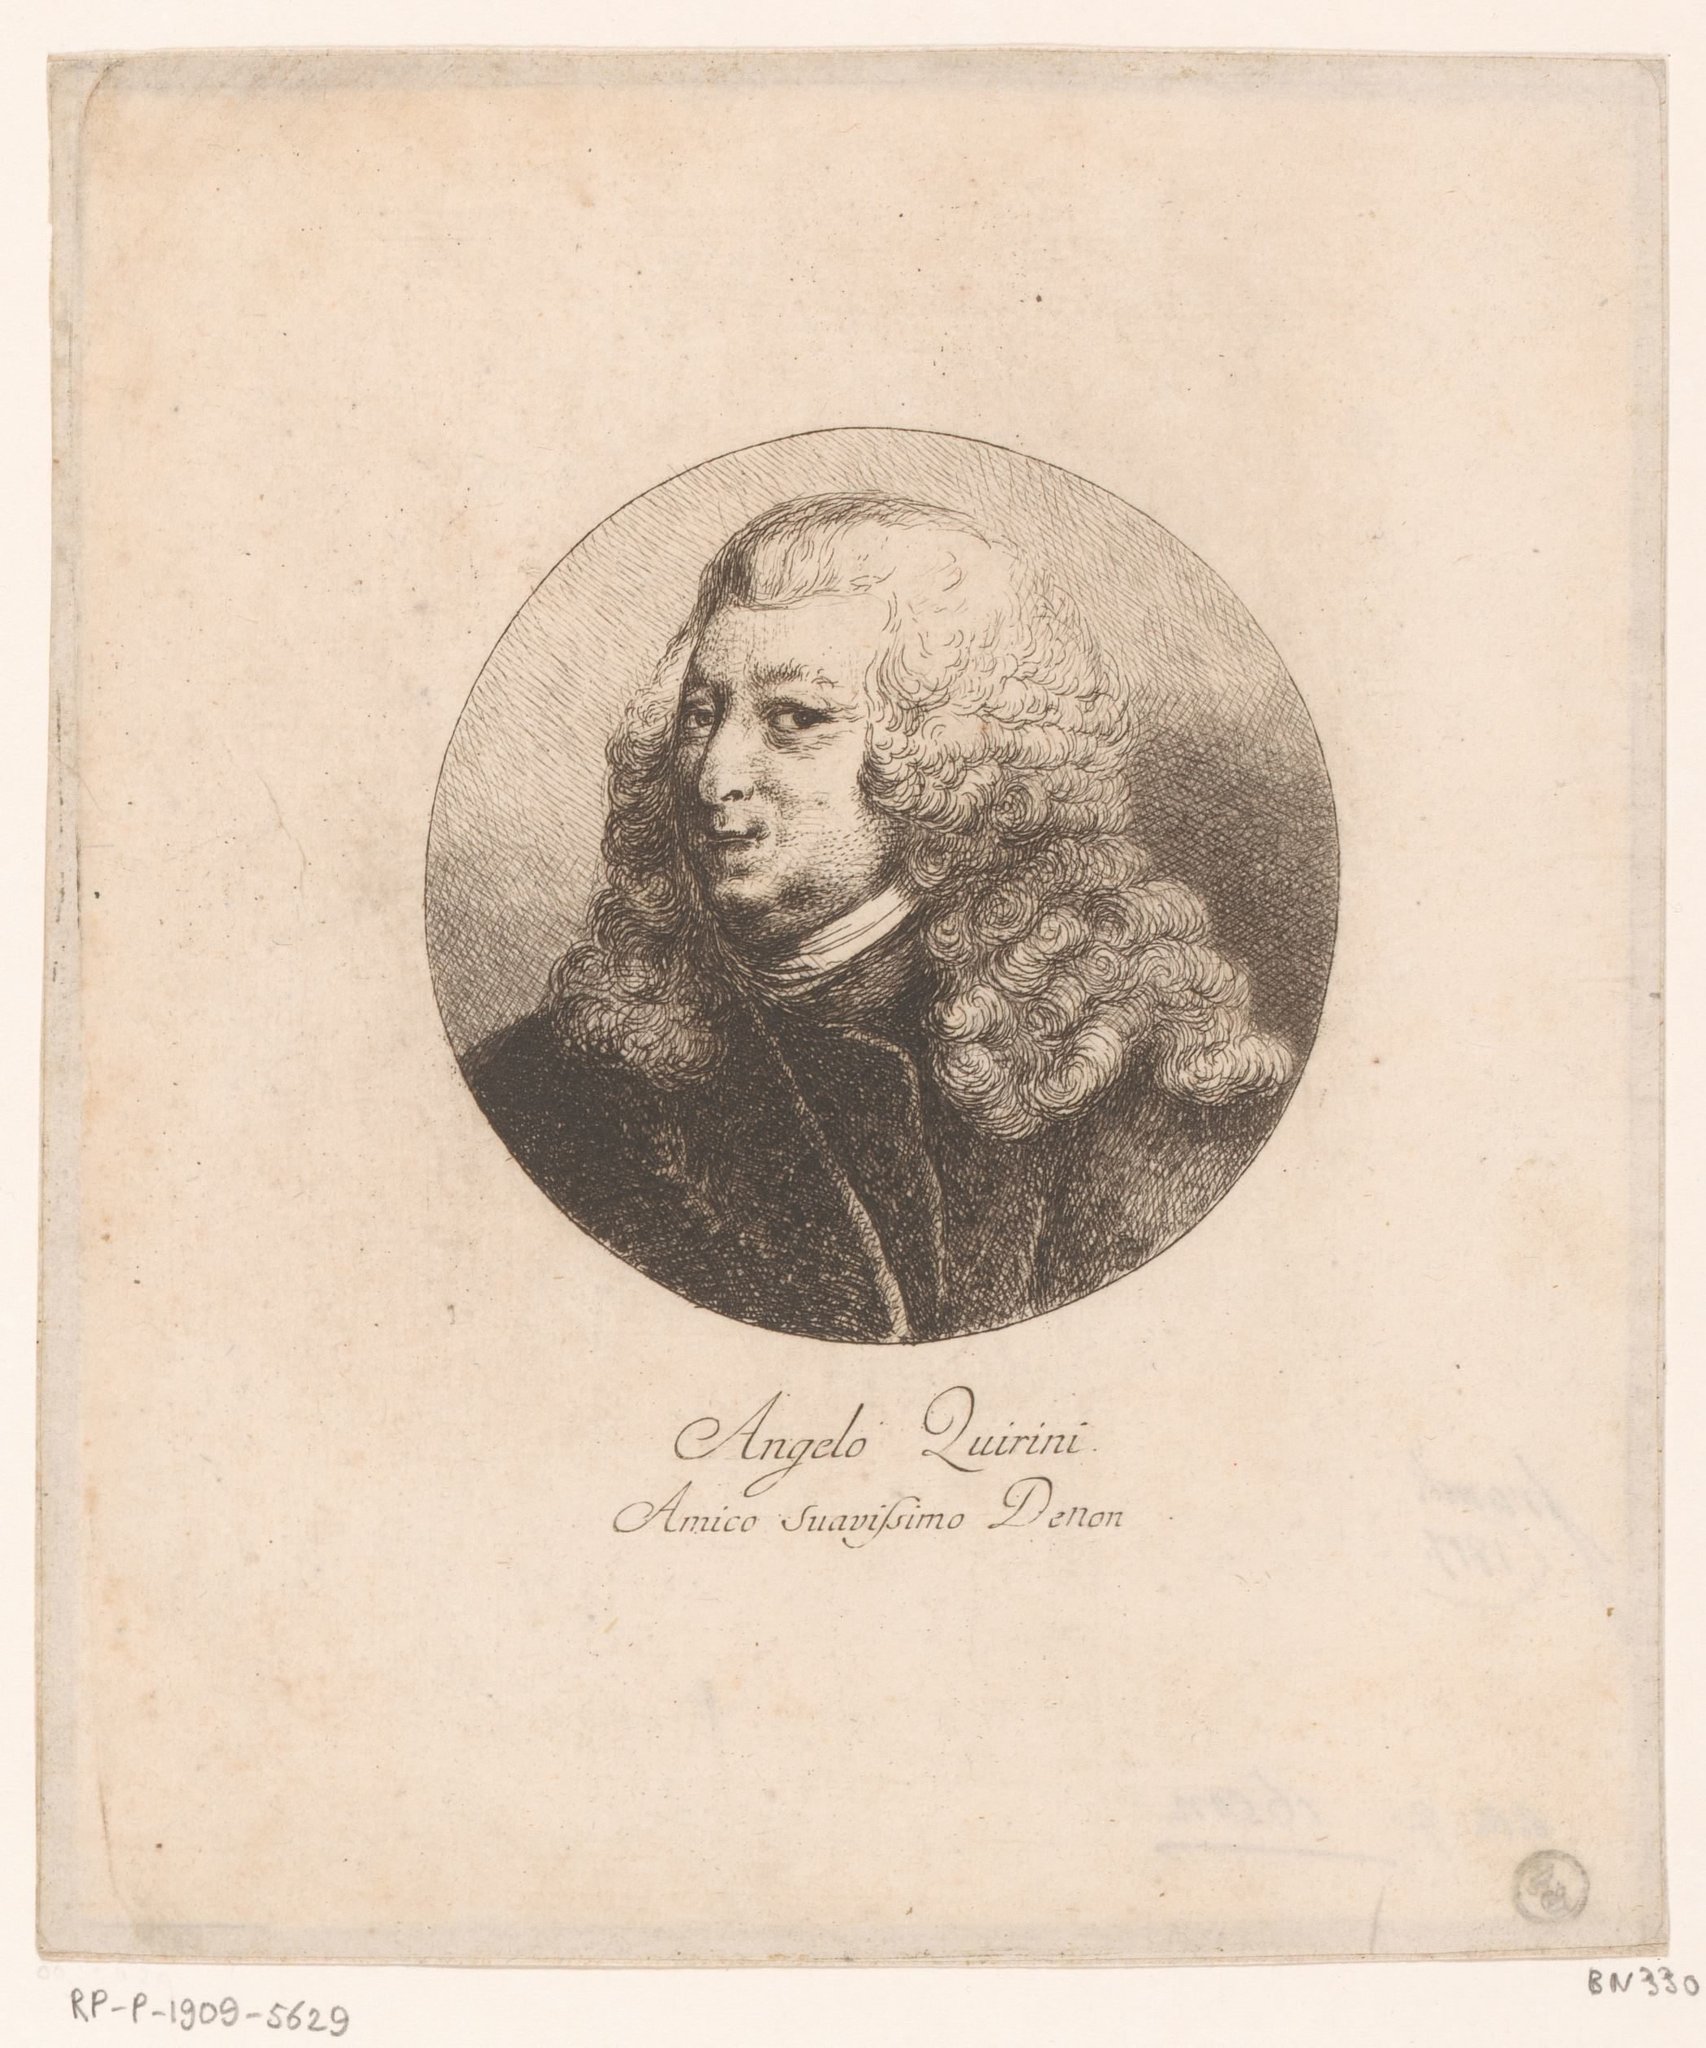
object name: print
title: Portret van Angelo Quirini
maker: dominique vivant denon (baron)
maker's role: draughtsman, print maker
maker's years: 1747-1825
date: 1757-1803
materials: paper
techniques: etching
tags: politician, historical persons, politician, e.g. party leader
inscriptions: collector's mark: Lugt 2228